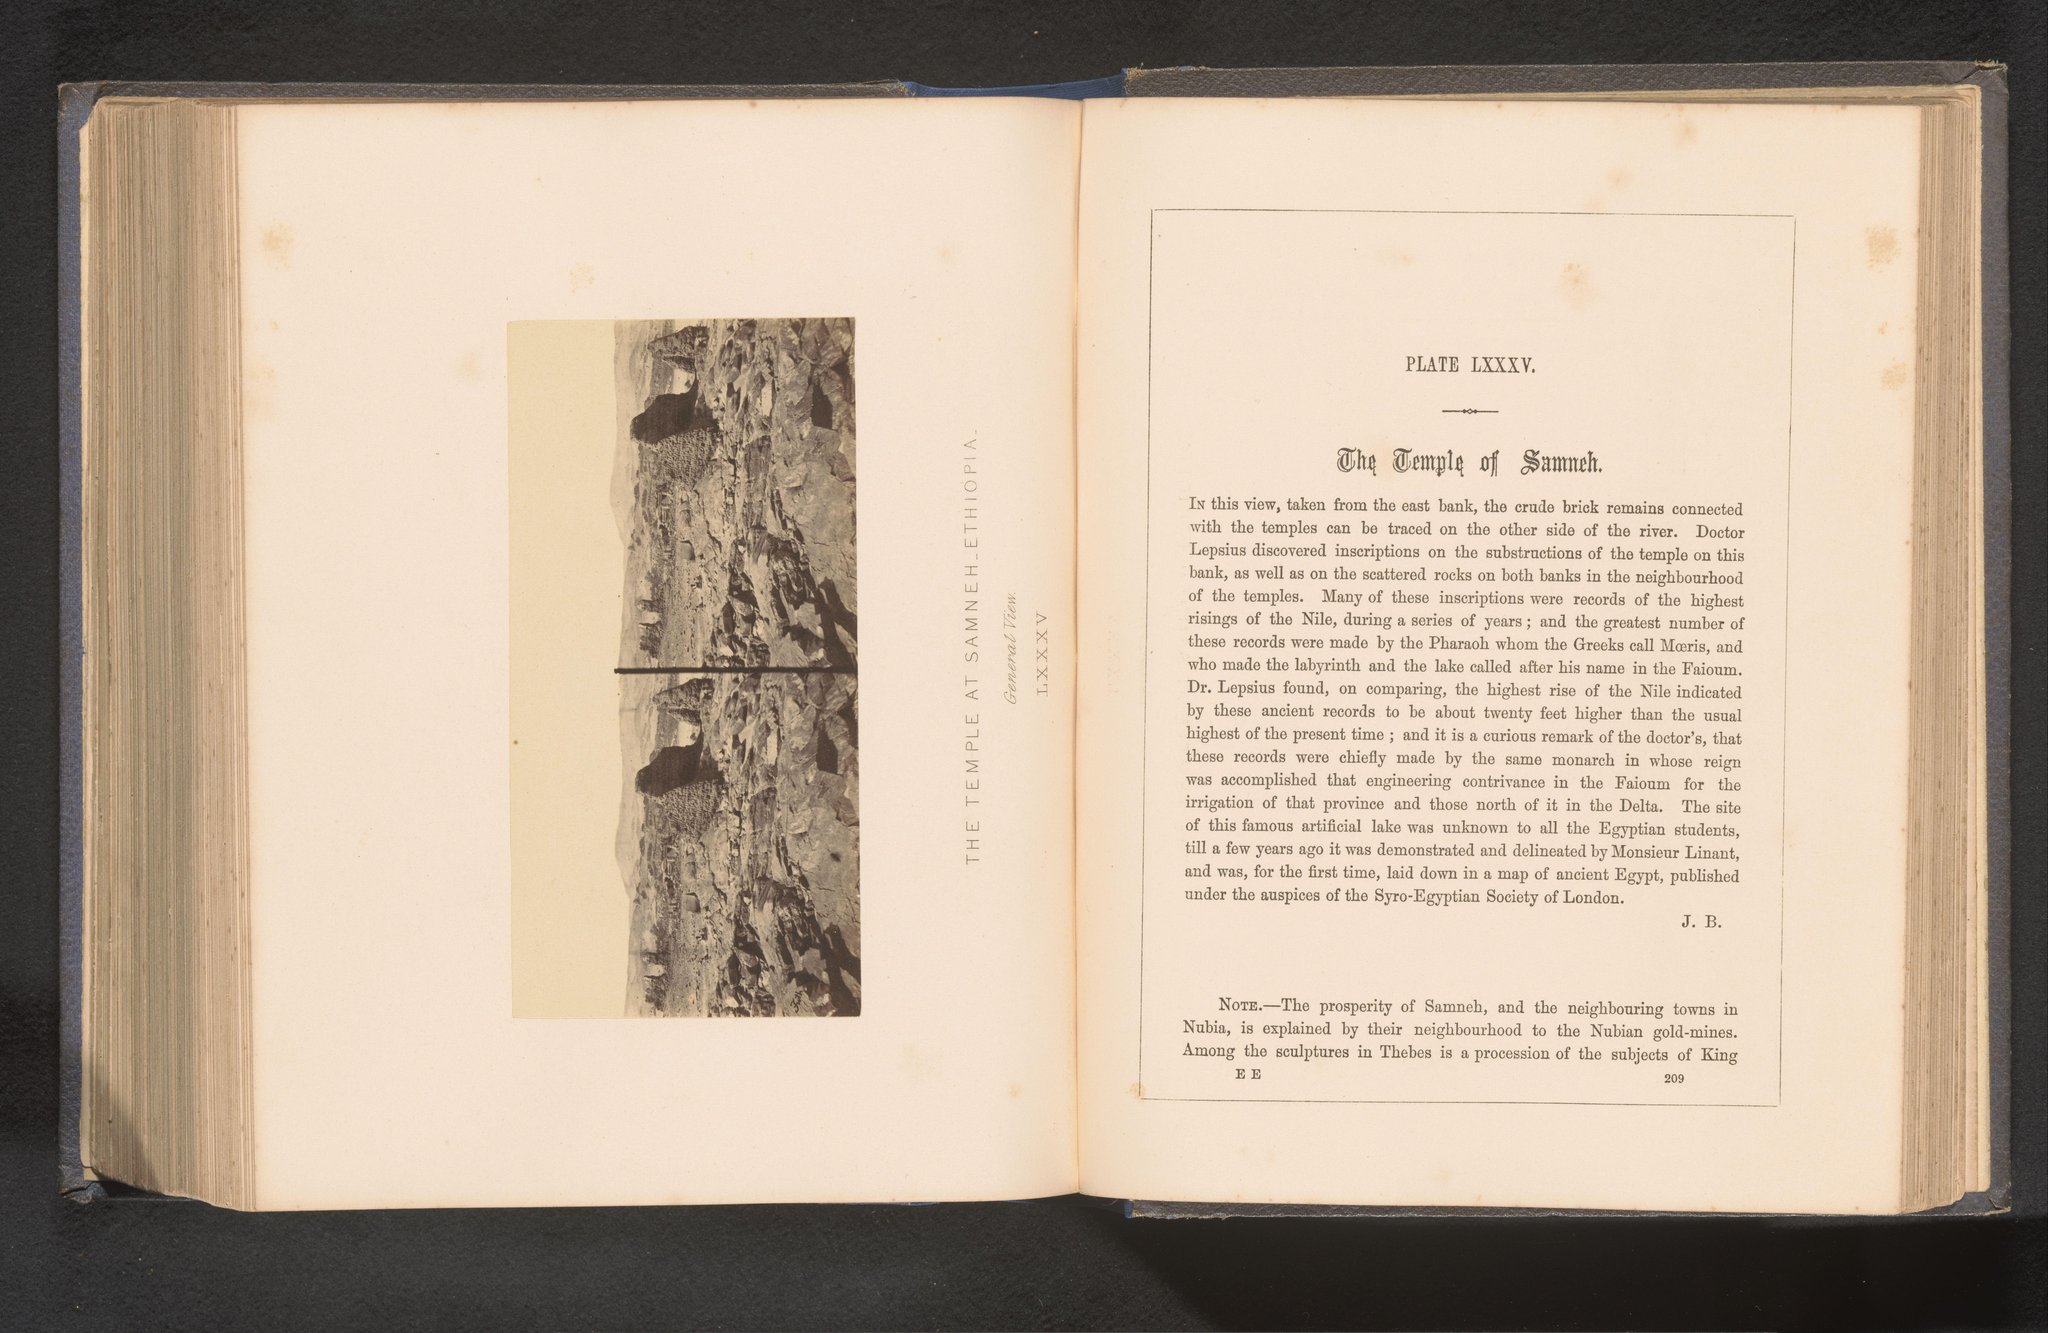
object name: page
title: Gezicht op Semna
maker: francis frith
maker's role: publisher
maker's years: 1822-1898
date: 1857-1862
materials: photographic support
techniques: albumen print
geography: semna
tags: landscapes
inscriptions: inscription: ‘General View’, number: ‘LXXXV’, name: ‘Frith’